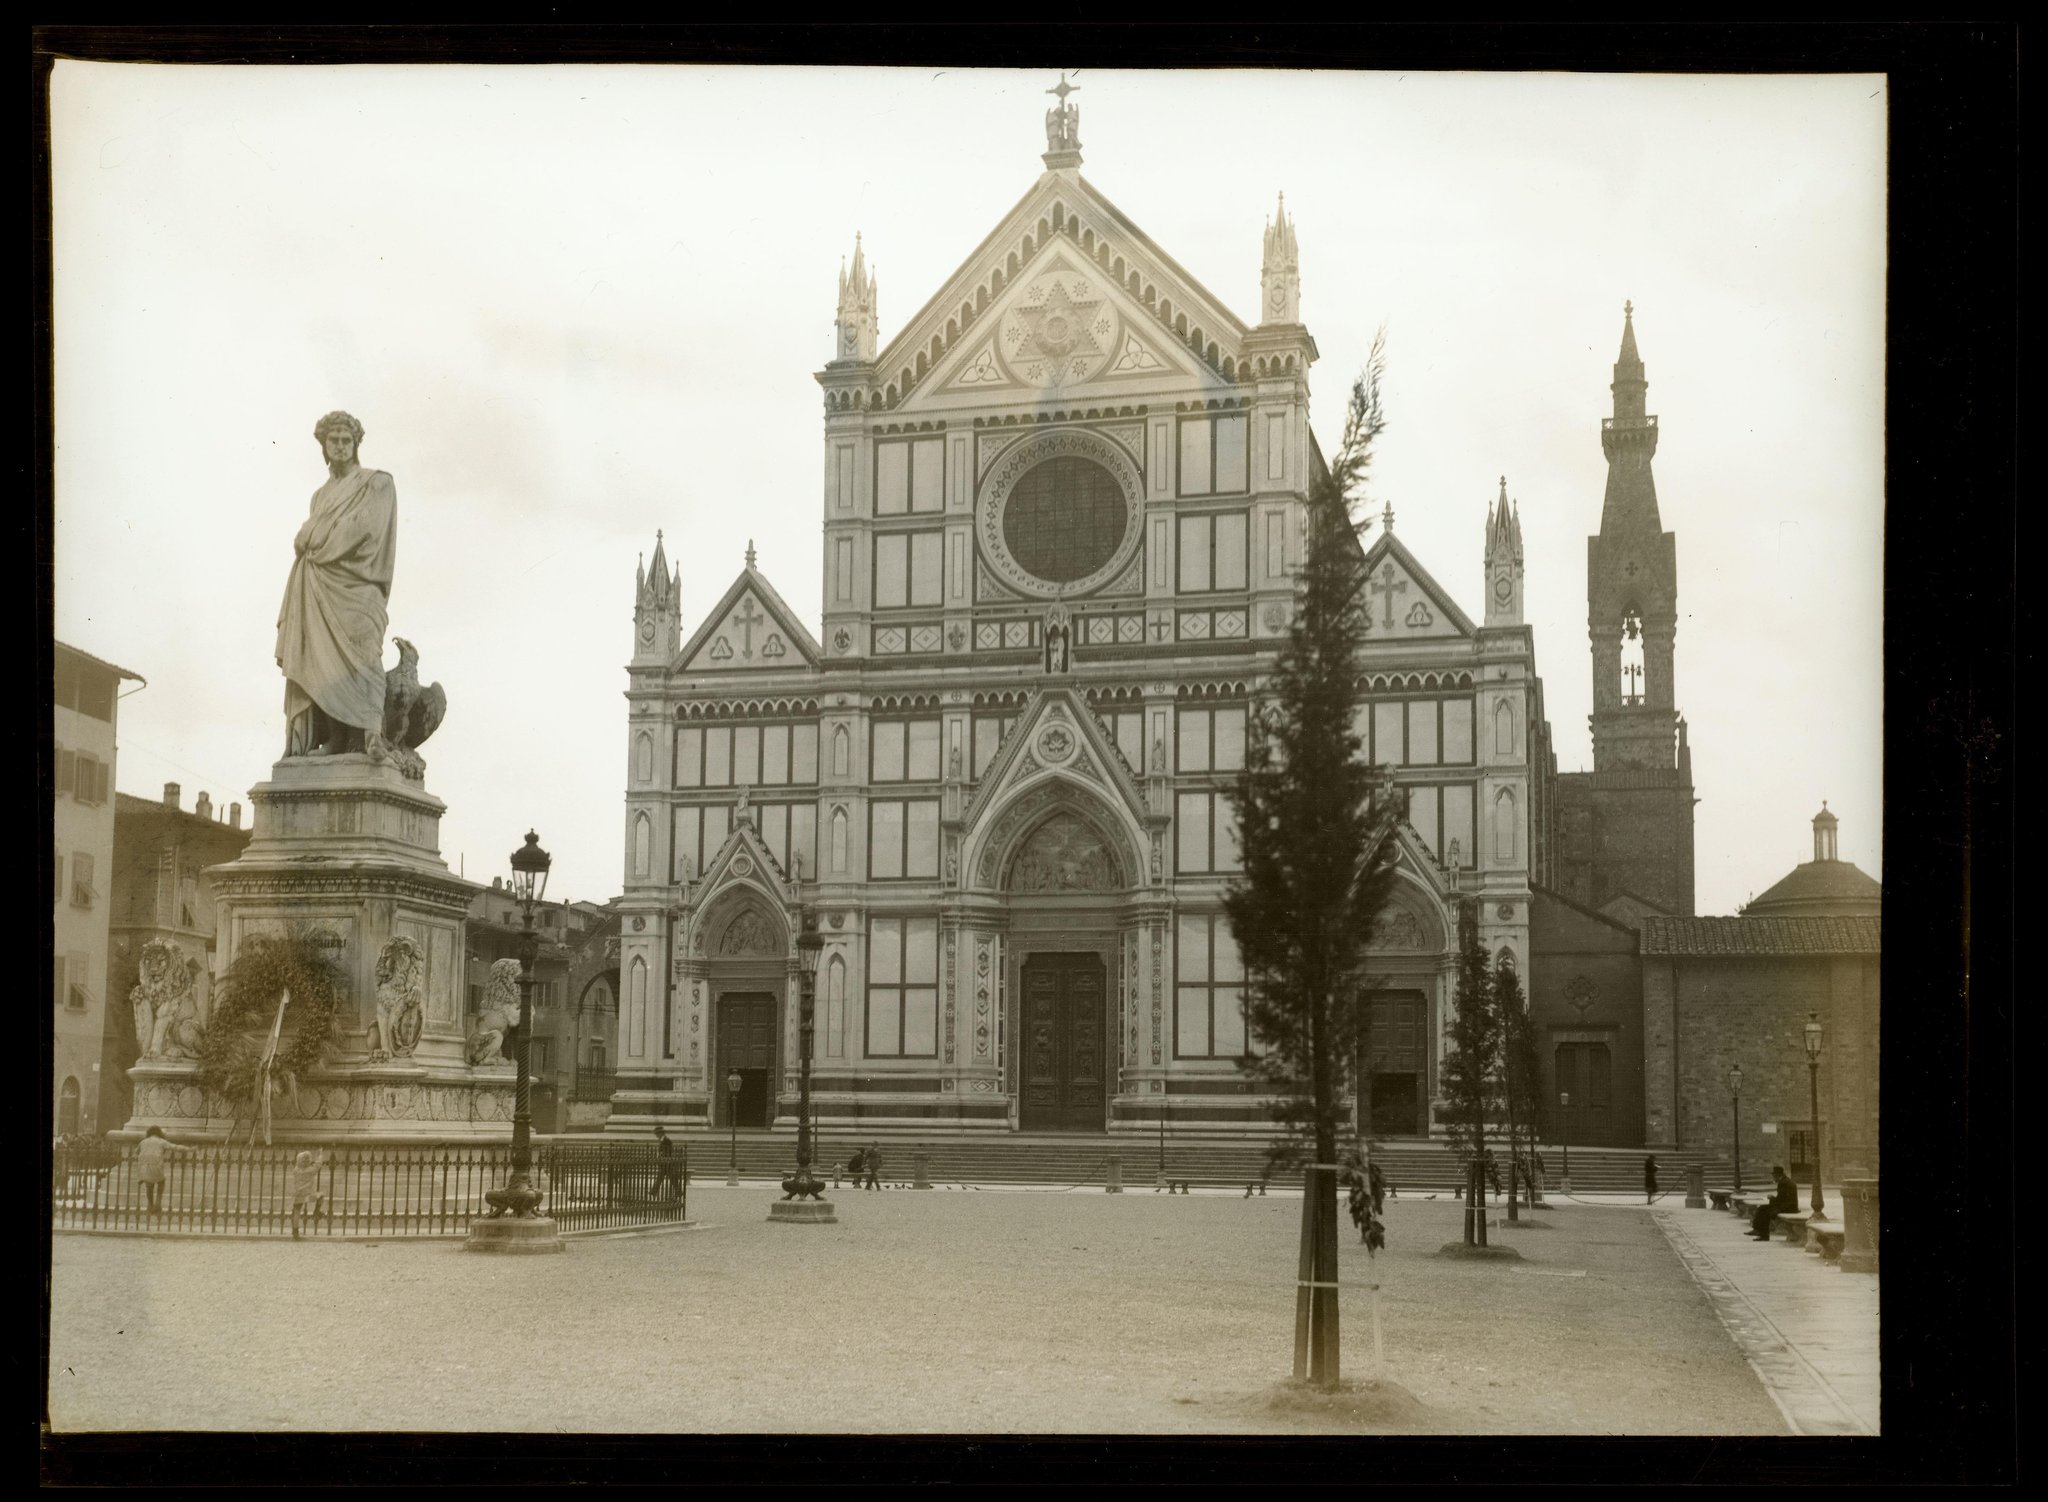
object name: photograph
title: Filmnegatief met opname van Florence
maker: Anonymous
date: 1907-1935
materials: film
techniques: gelatin silver negative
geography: florence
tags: florence